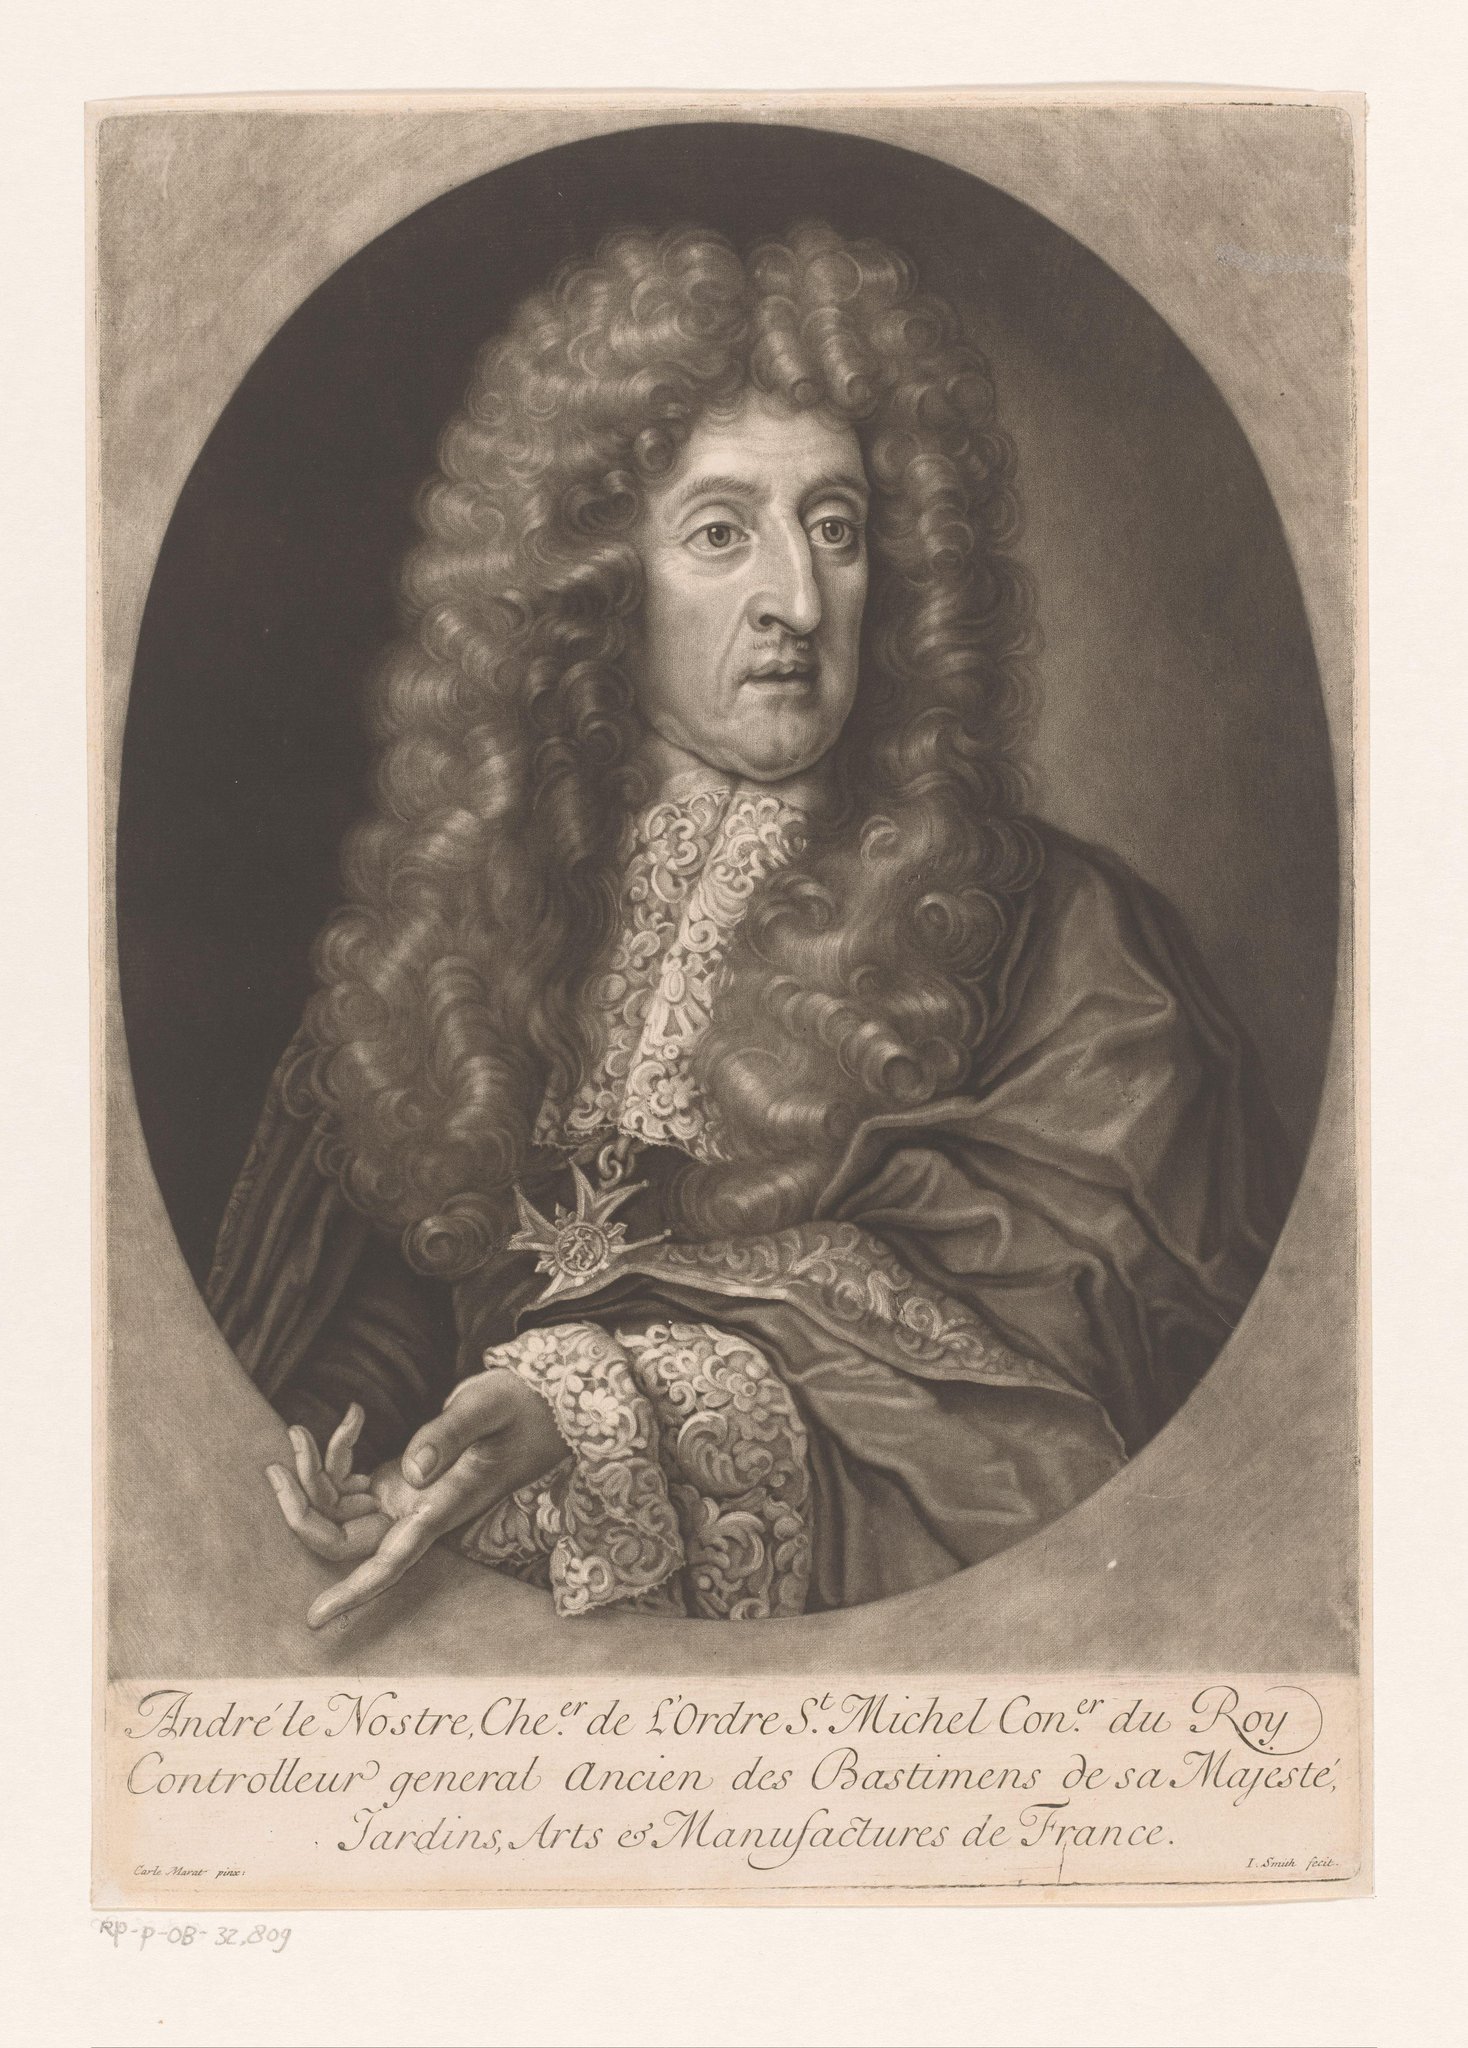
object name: print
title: Portret van André le Nôtre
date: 1662-1742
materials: paper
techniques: mezzotint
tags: historical persons, portrait, self-portrait of architect, index finger forwards, pointing, indicating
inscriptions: collector's mark: Lugt 240